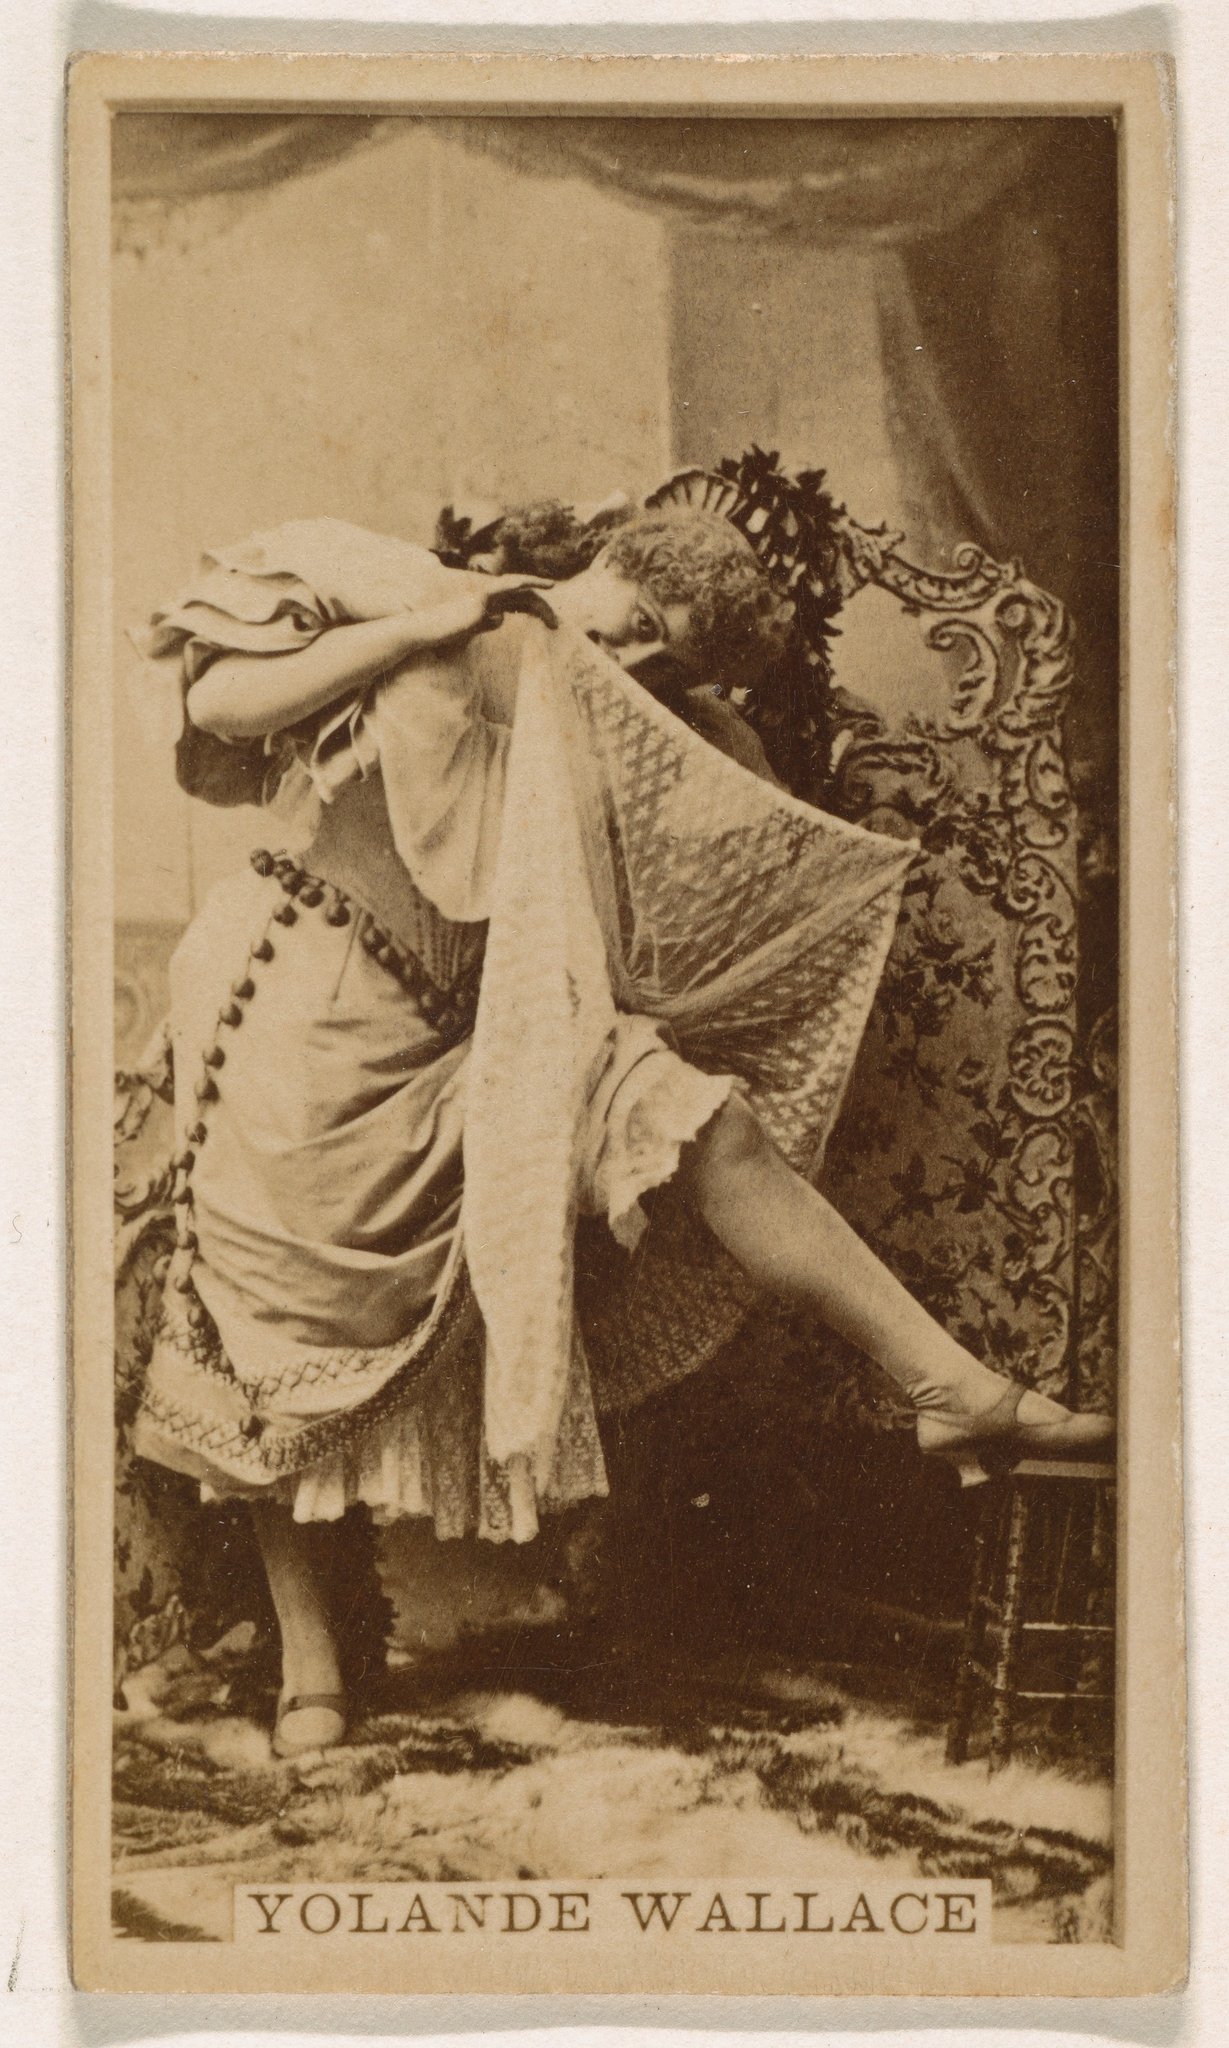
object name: photograph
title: Yolande Wallace, from the Actresses series (N245) issued by Kinney Brothers to promote Sweet Caporal Cigarettes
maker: kinney brothers tobacco company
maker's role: publisher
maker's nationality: american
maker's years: 1869-2011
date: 1890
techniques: albumen silver print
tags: portraits,women,actresses